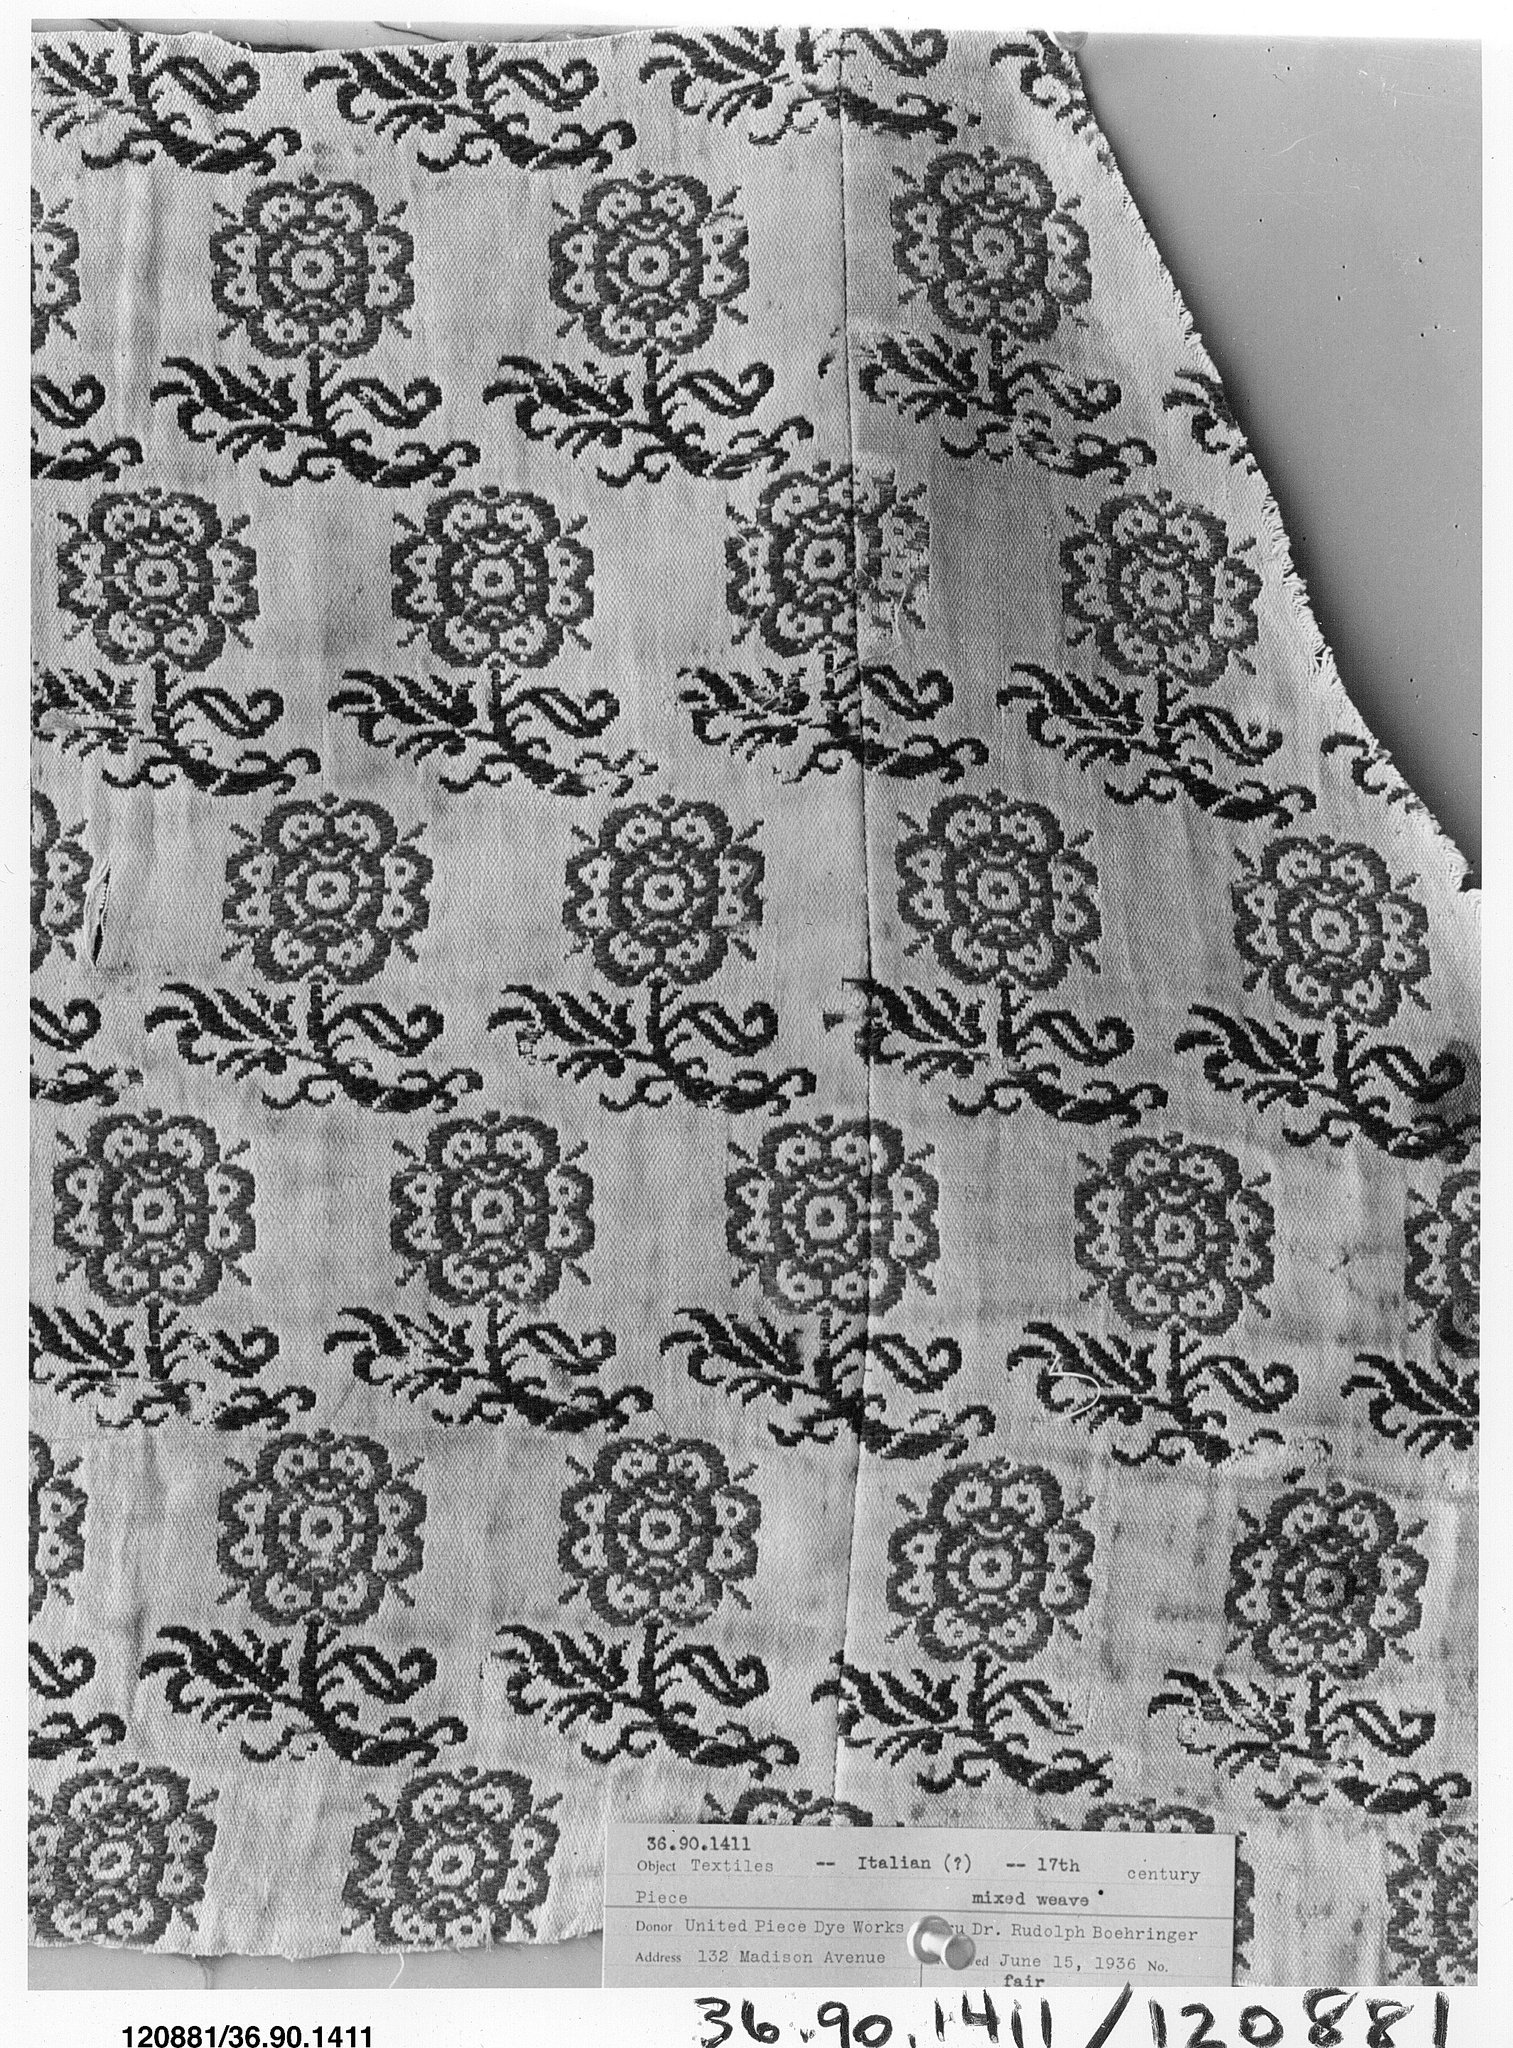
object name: piece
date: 1601-1700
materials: linen, wool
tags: flowers